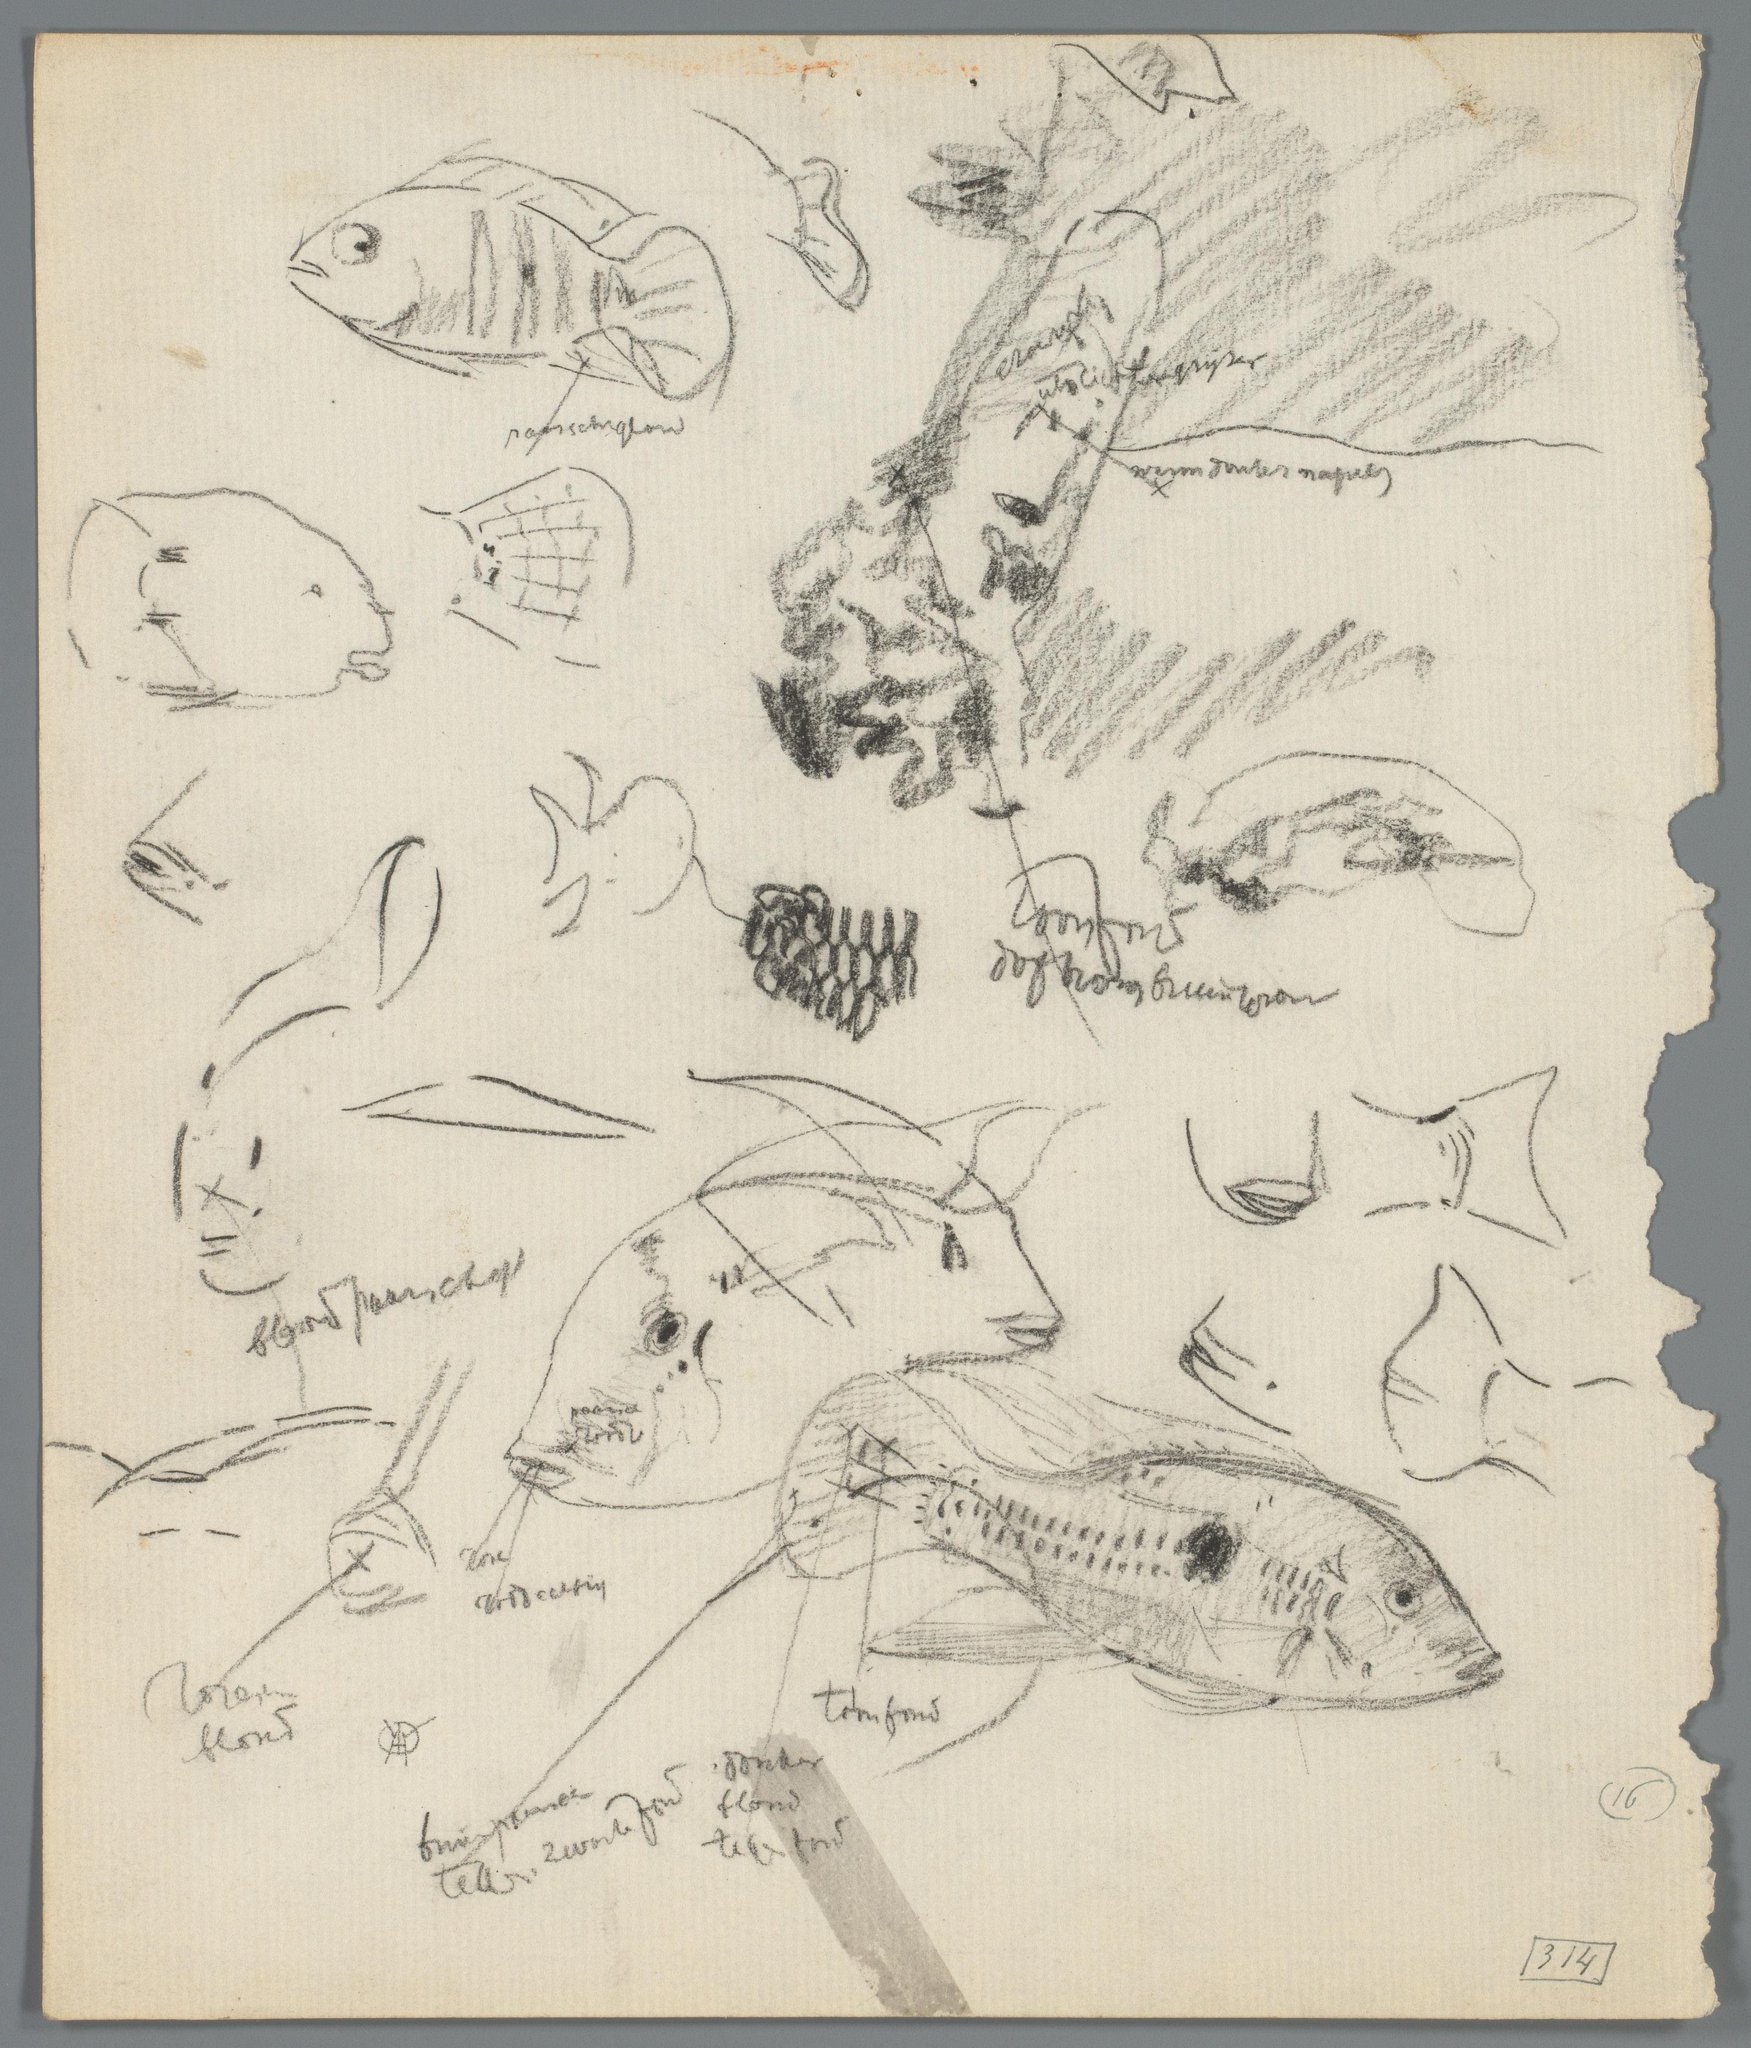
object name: drawing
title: Studieblad met vissen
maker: gerrit willem dijsselhof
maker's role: designer, draughtsman, print maker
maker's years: 1866-1924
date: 1876-1924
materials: chalk, paper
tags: bony fishes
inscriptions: number: ‘16’, number: ‘314’